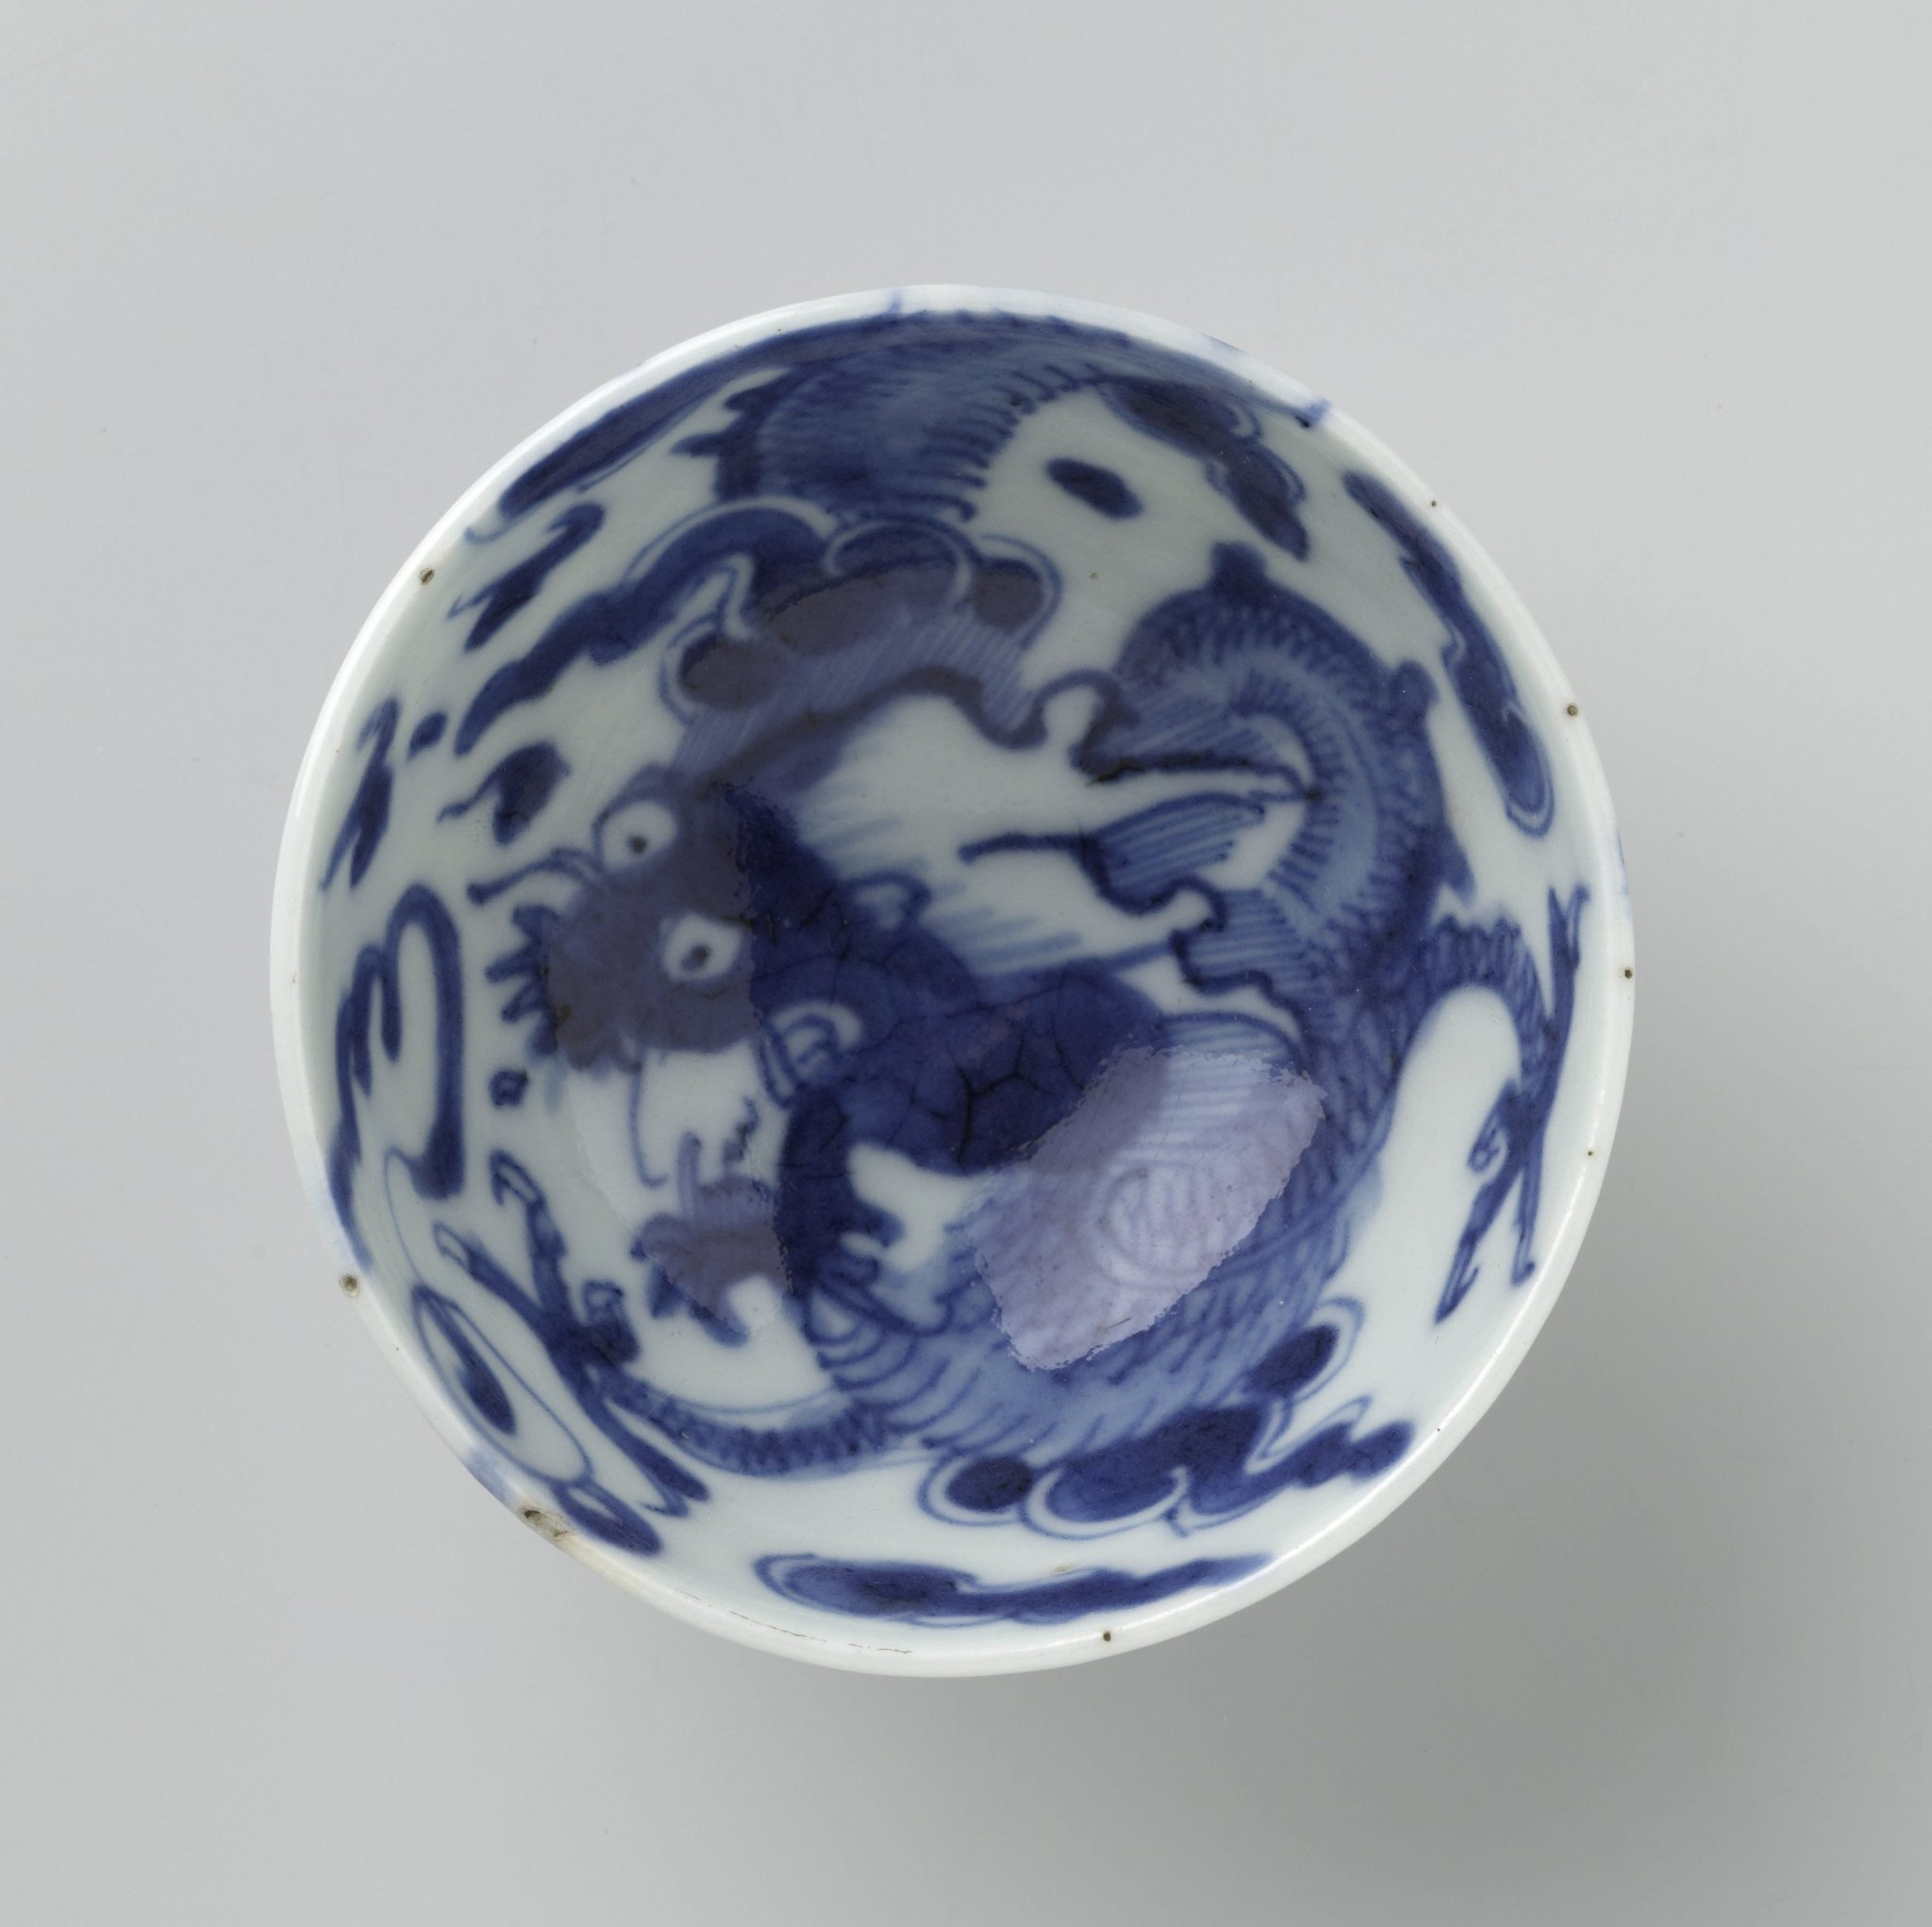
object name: cup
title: Cup with a pearl chasing dragon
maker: Anonymous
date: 1750-1774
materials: cobalt, glaze, paint, porcelain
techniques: firing, turning, vitrification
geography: china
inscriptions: mark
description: Kop van porselein met iets spreidende wand, beschilderd in onderglazuur blauw. Op de binnen- en buitenzijde een doorlopende vierklauwige draak een parel najagend, de staart aan de buitenzijde en de kop aan de binnenzijde; de draak is omgeven door wolkmotieven. Gemerkt op de onderzijde met een zegelmerk in een dubbele cirkel. Blauw-wit.